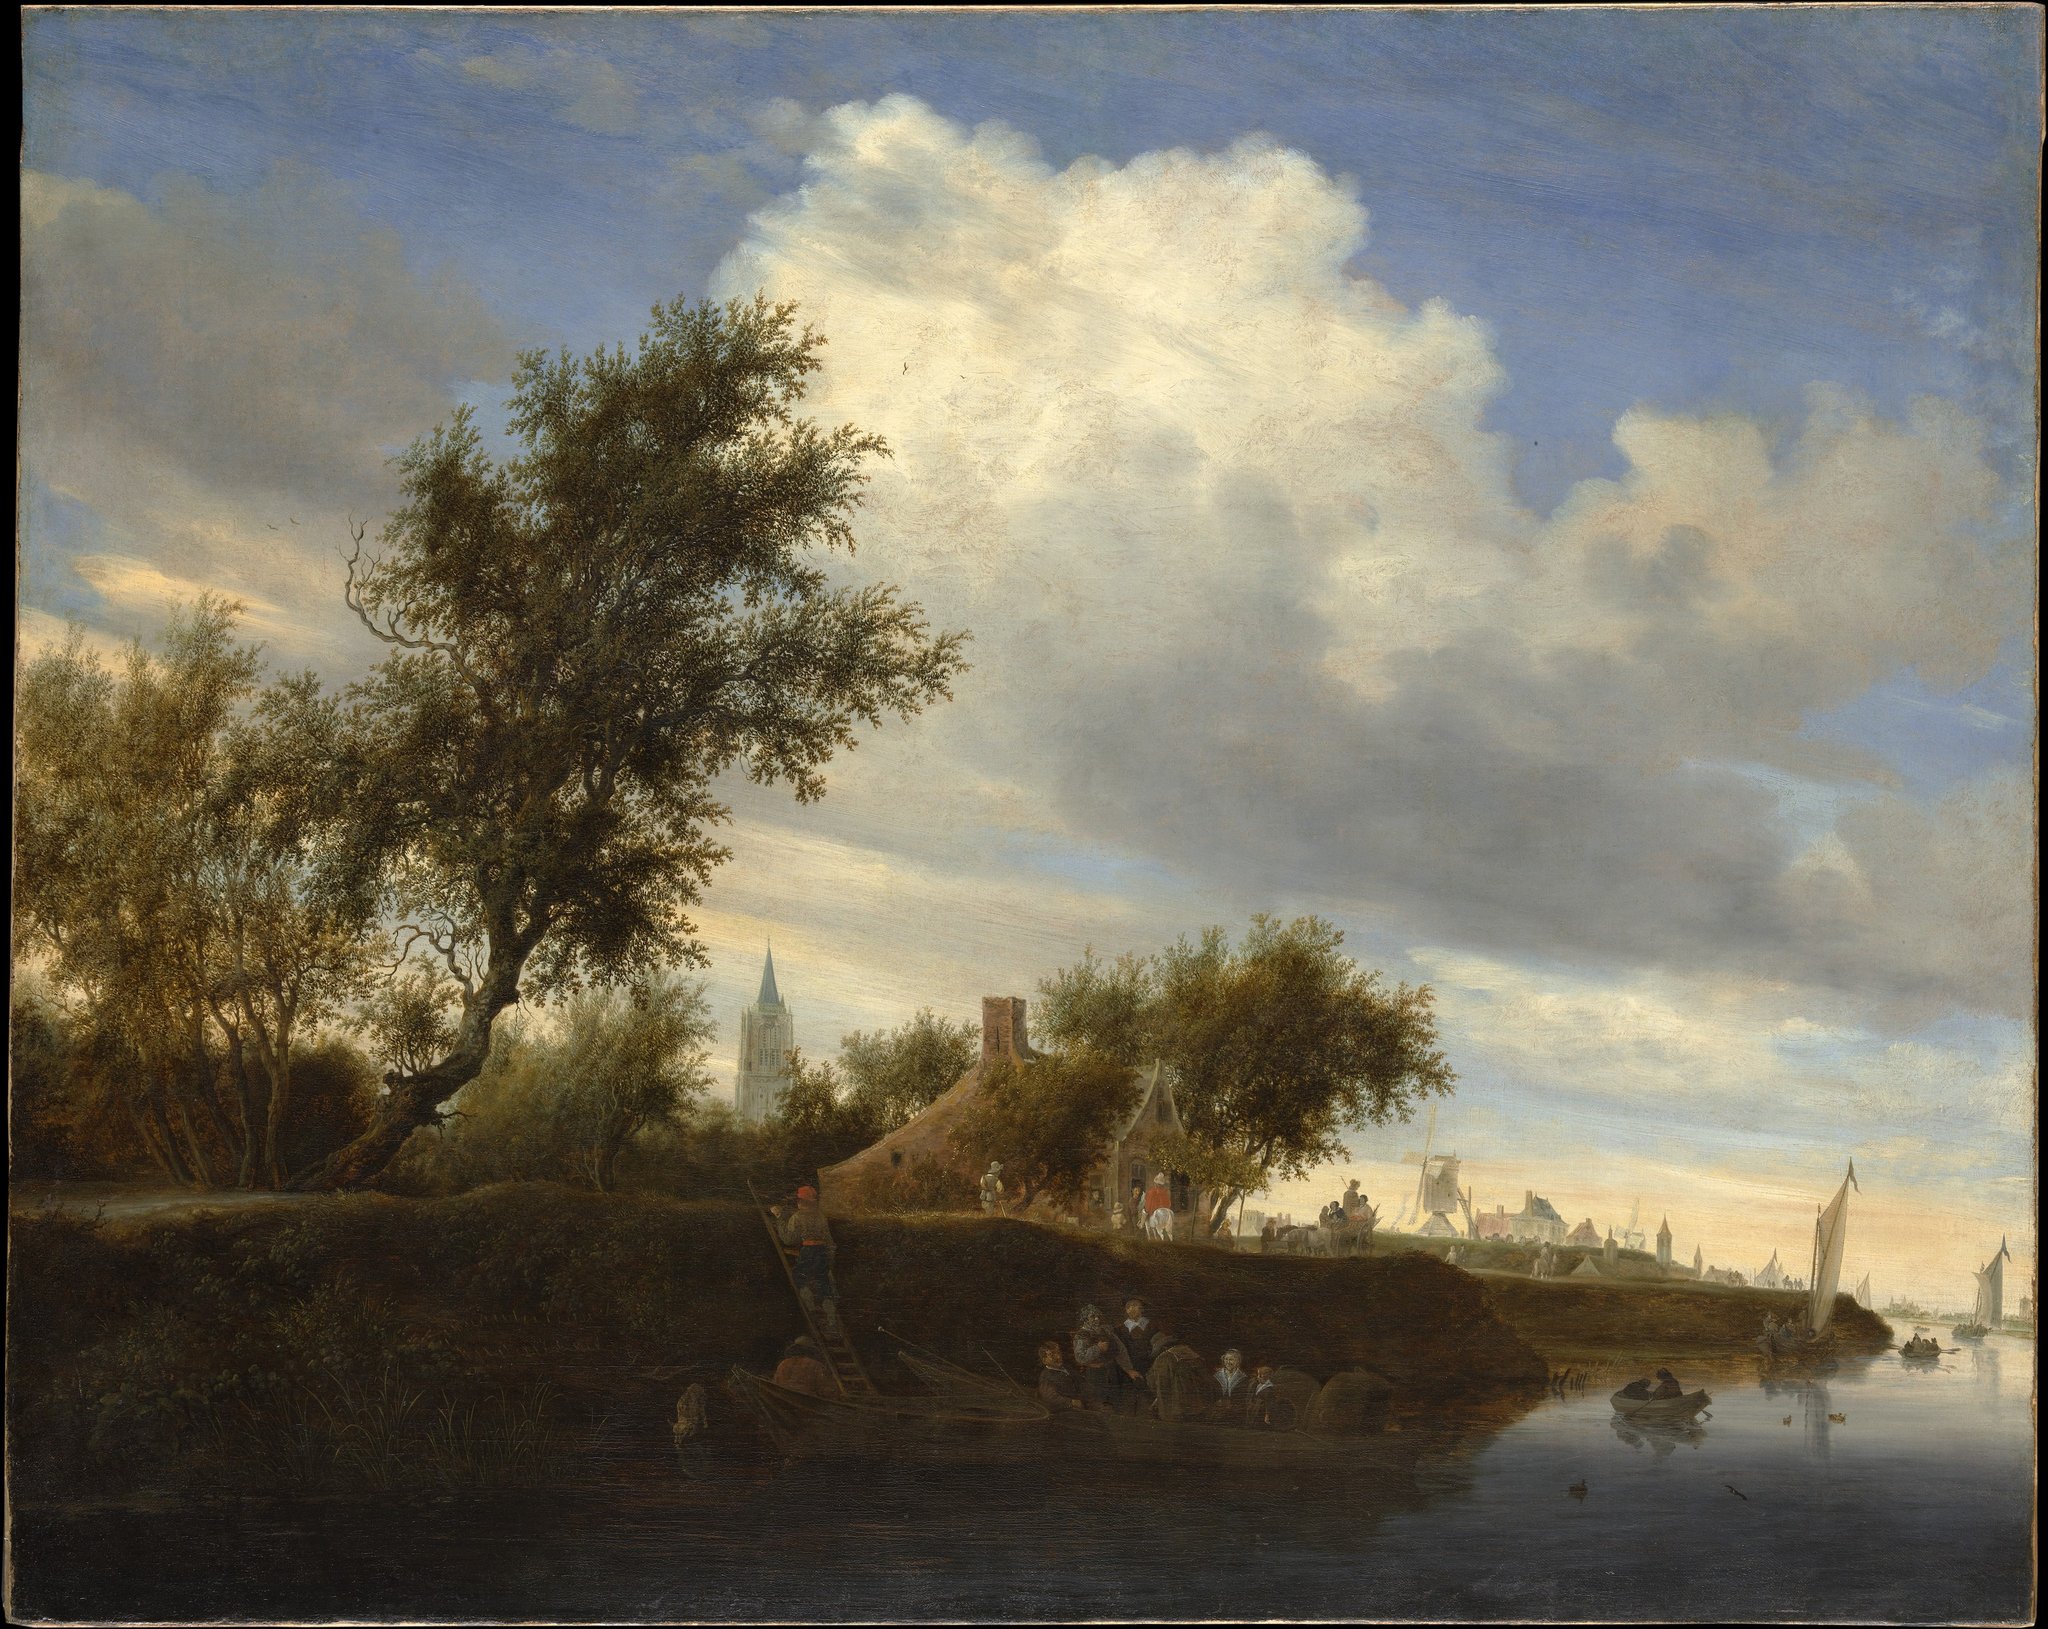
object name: painting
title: Ferry near Gorinchem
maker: salomon van ruysdael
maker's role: artist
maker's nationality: dutch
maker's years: 1600-1670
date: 1646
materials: canvas, oil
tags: human figures,windmills,rivers,boats